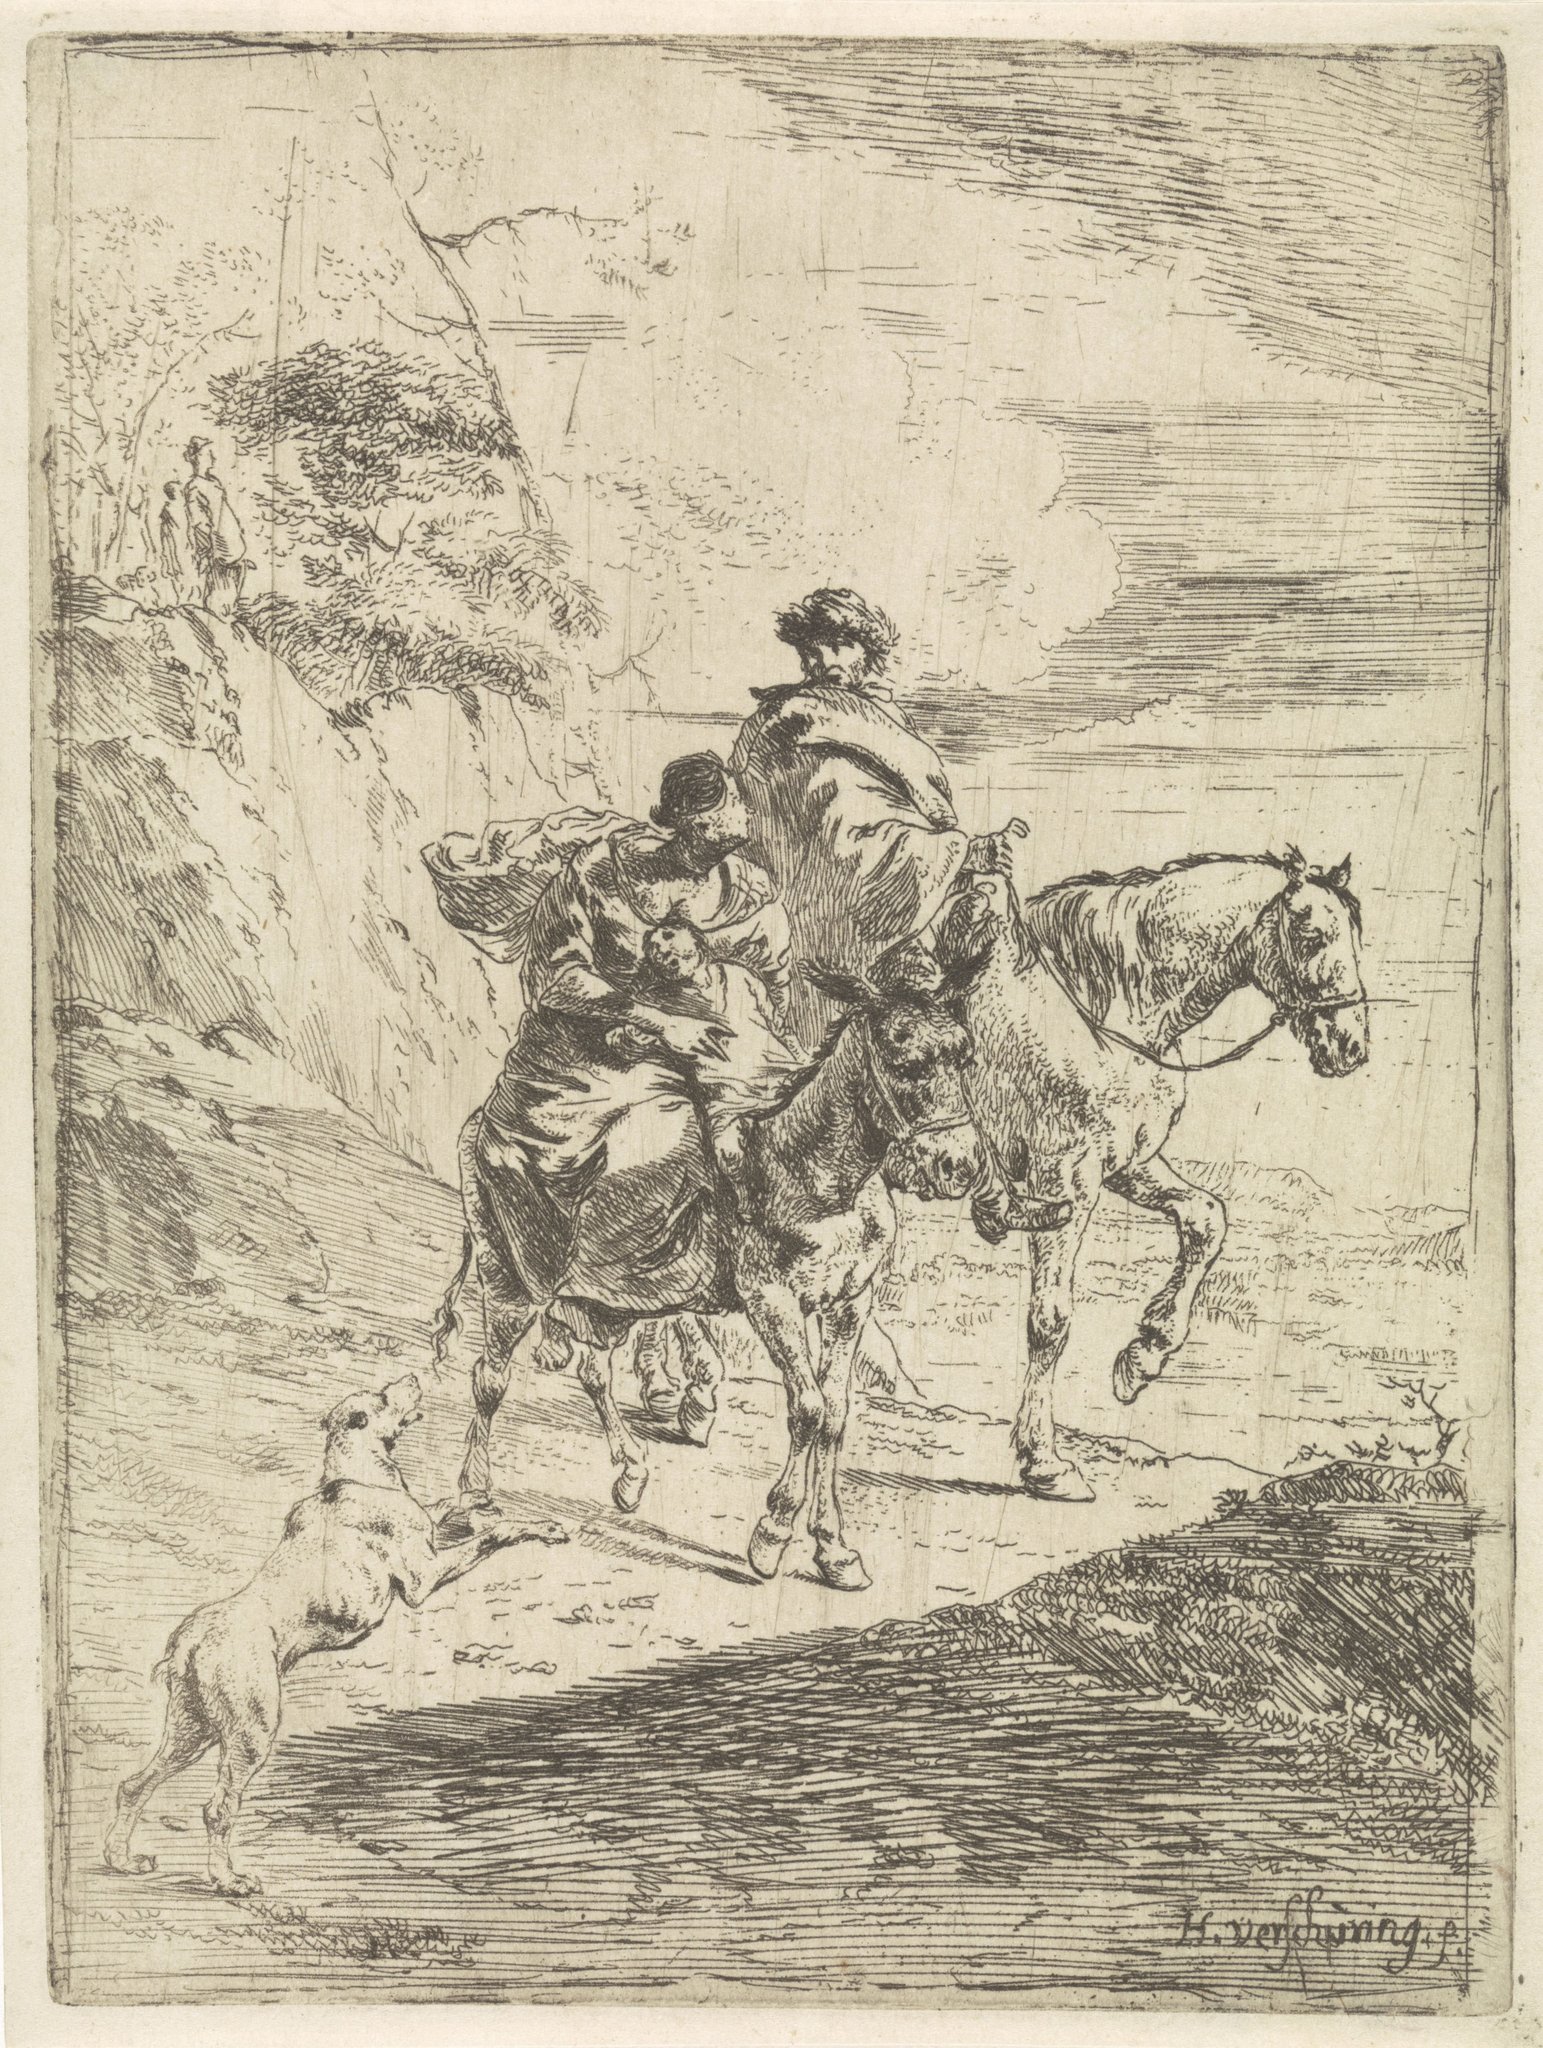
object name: print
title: Reizigers in een berglandschap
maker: hendrik verschuring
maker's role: draughtsman, print maker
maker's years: 1627-1690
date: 1635-1690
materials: paper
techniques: etching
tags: riding a horse, ass, or mule; rider, horseman, ass, donkey, 'en route', traveller under way, dog, mountains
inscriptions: collector's mark: ‘F. Rechberger 1800’ Lugt 2133, collector's mark: Lugt 12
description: Man te paard en een vrouw met kind, zittend op een ezel, in een berglandschap. Op de voorgrond en hond. Op de achtergrond twee figuren op een berghelling.